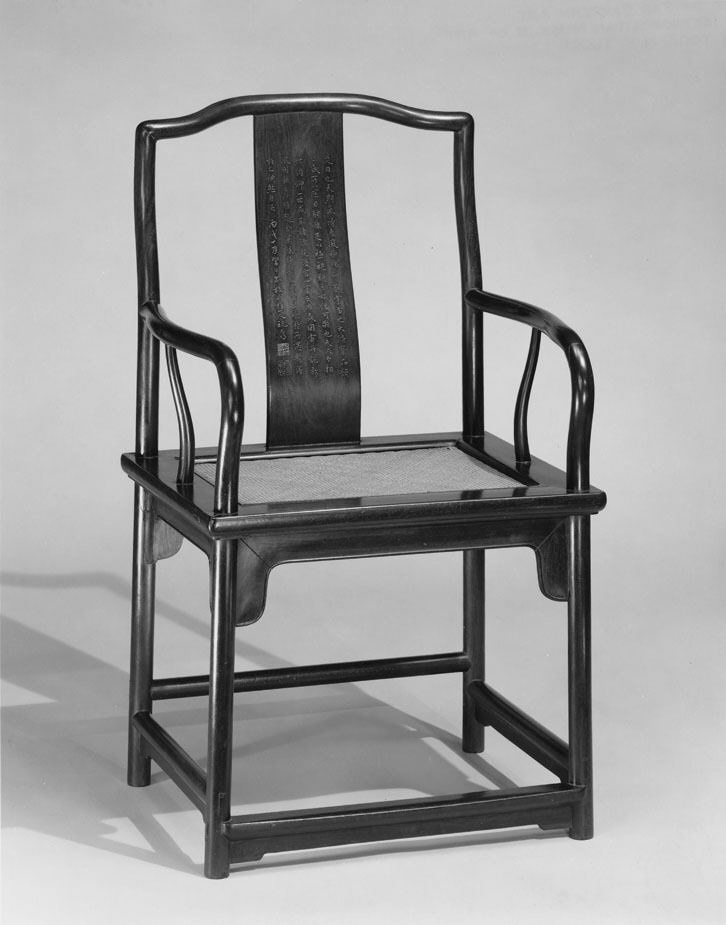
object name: armchair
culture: chinese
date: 1601-1700